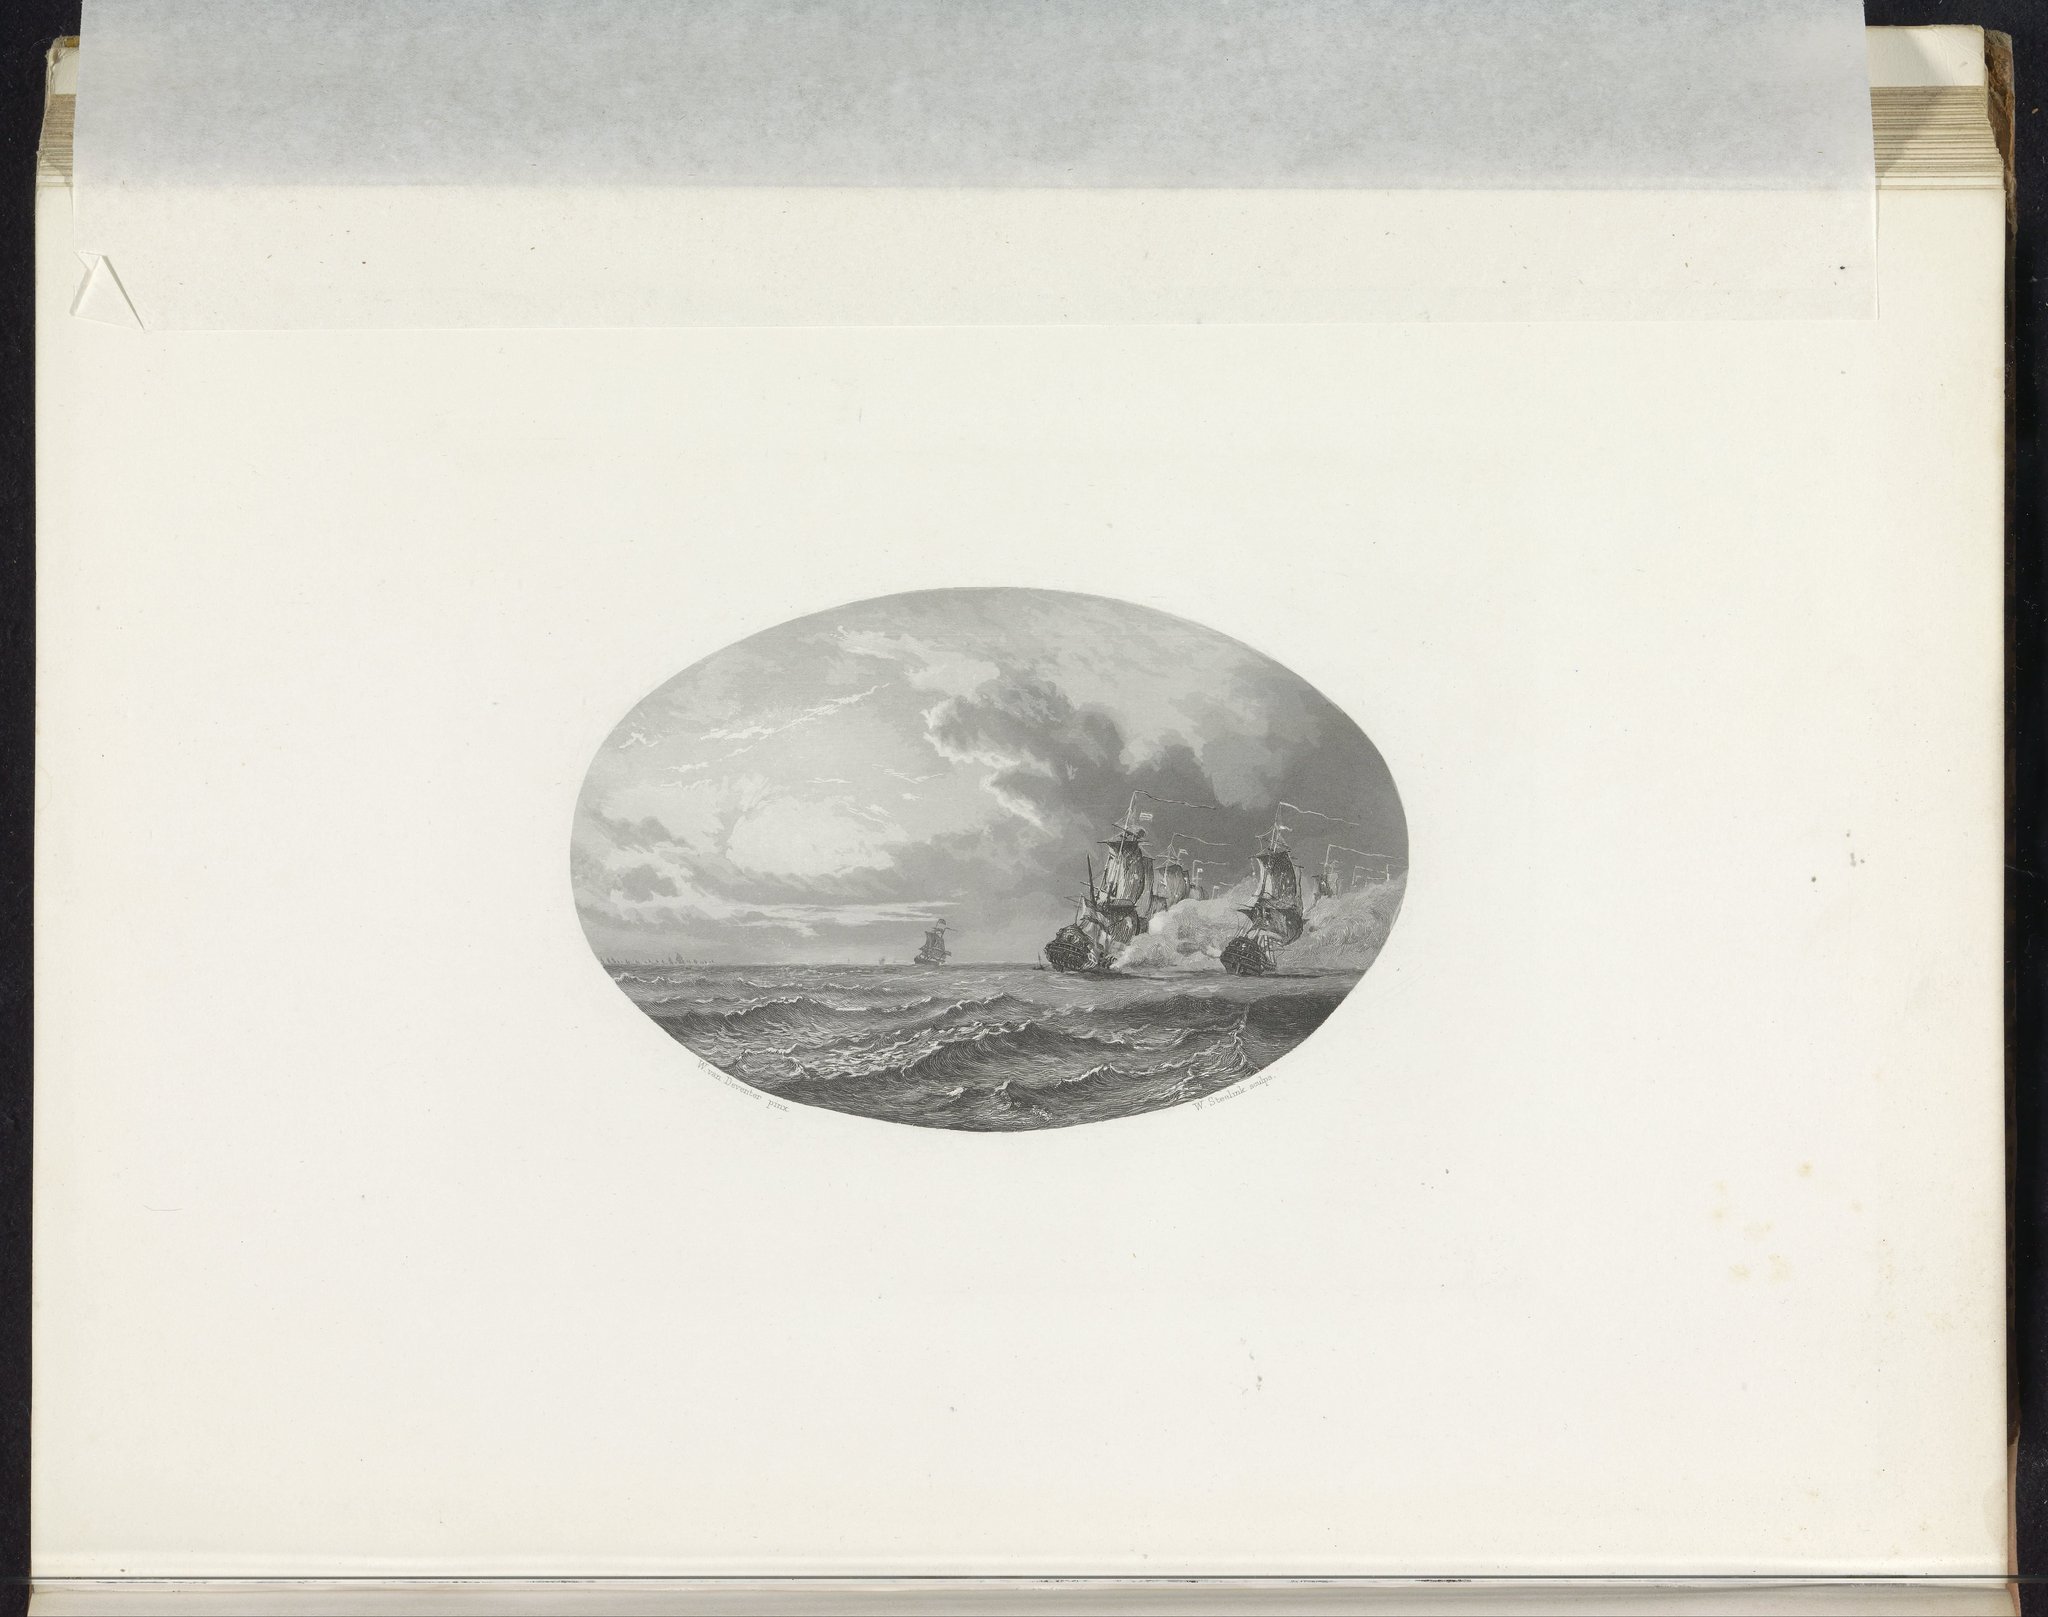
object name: print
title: De Vierdaagsche Zeeslag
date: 1865-1870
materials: paper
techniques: engraving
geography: netherlands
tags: battle (+ naval force)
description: Vierdaagse Zeeslag, tussen de Staatse en de Engelse vloot, tijdens de Tweede Engelse Oorlog, 11-14 juni 1666. Onderdeel van de groep staalgravures naar de schilderijen van de Historische Galerij der Maatschappij Arti et Amicitiae.